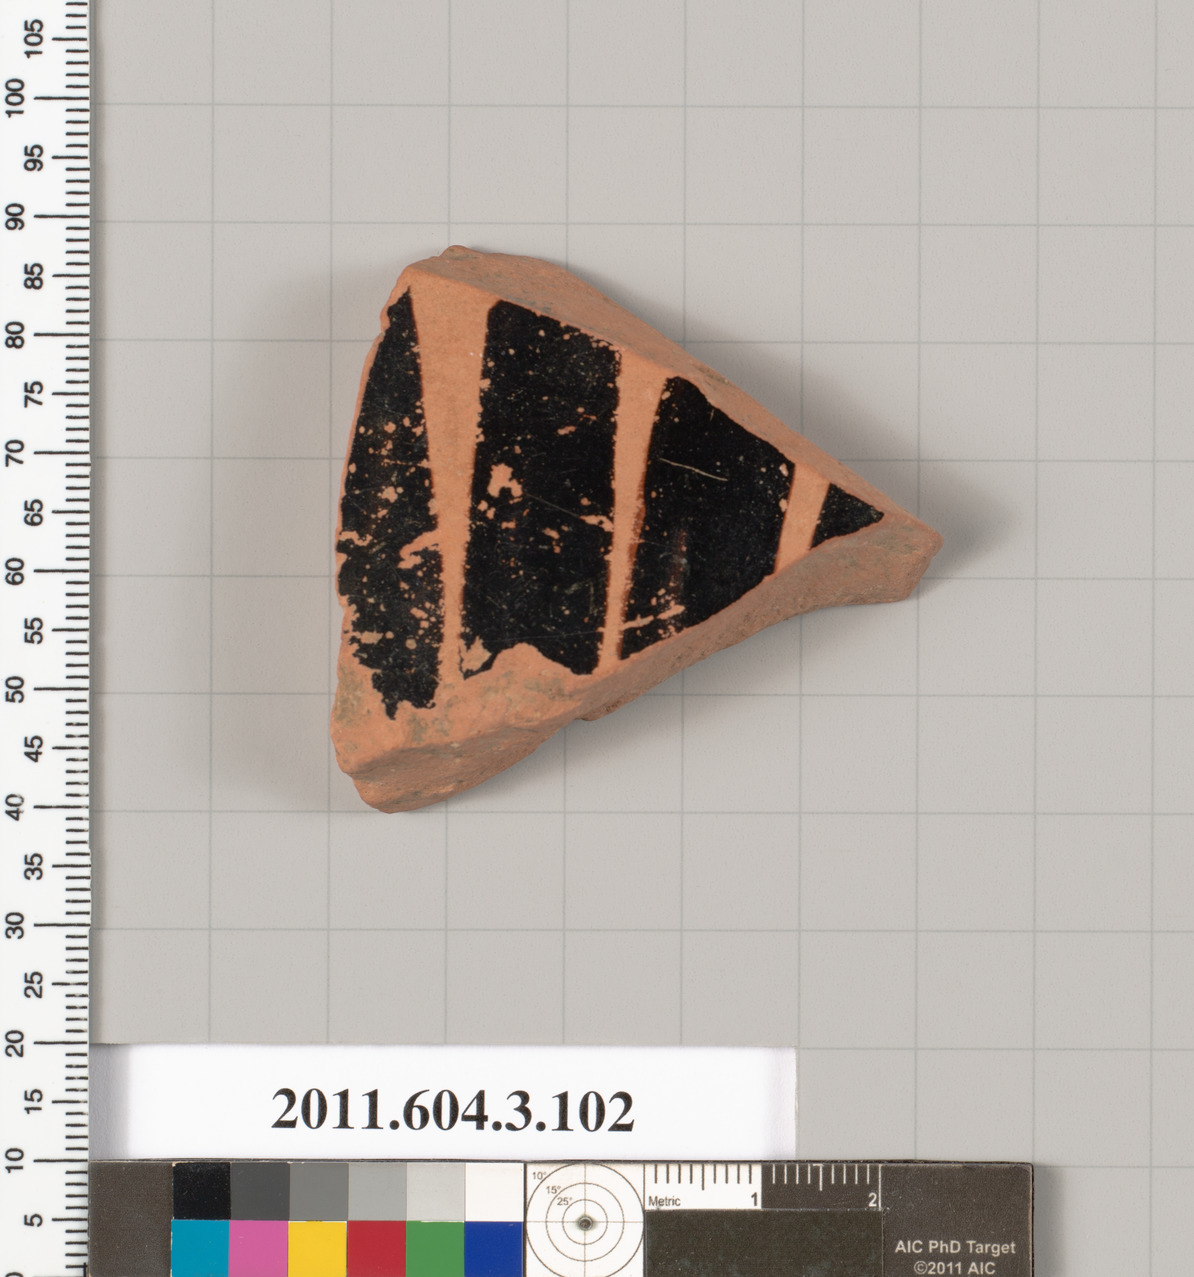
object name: amphora fragment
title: Terracotta fragment of an amphora (jar)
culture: greek, attic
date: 600-468 BCE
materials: terracotta